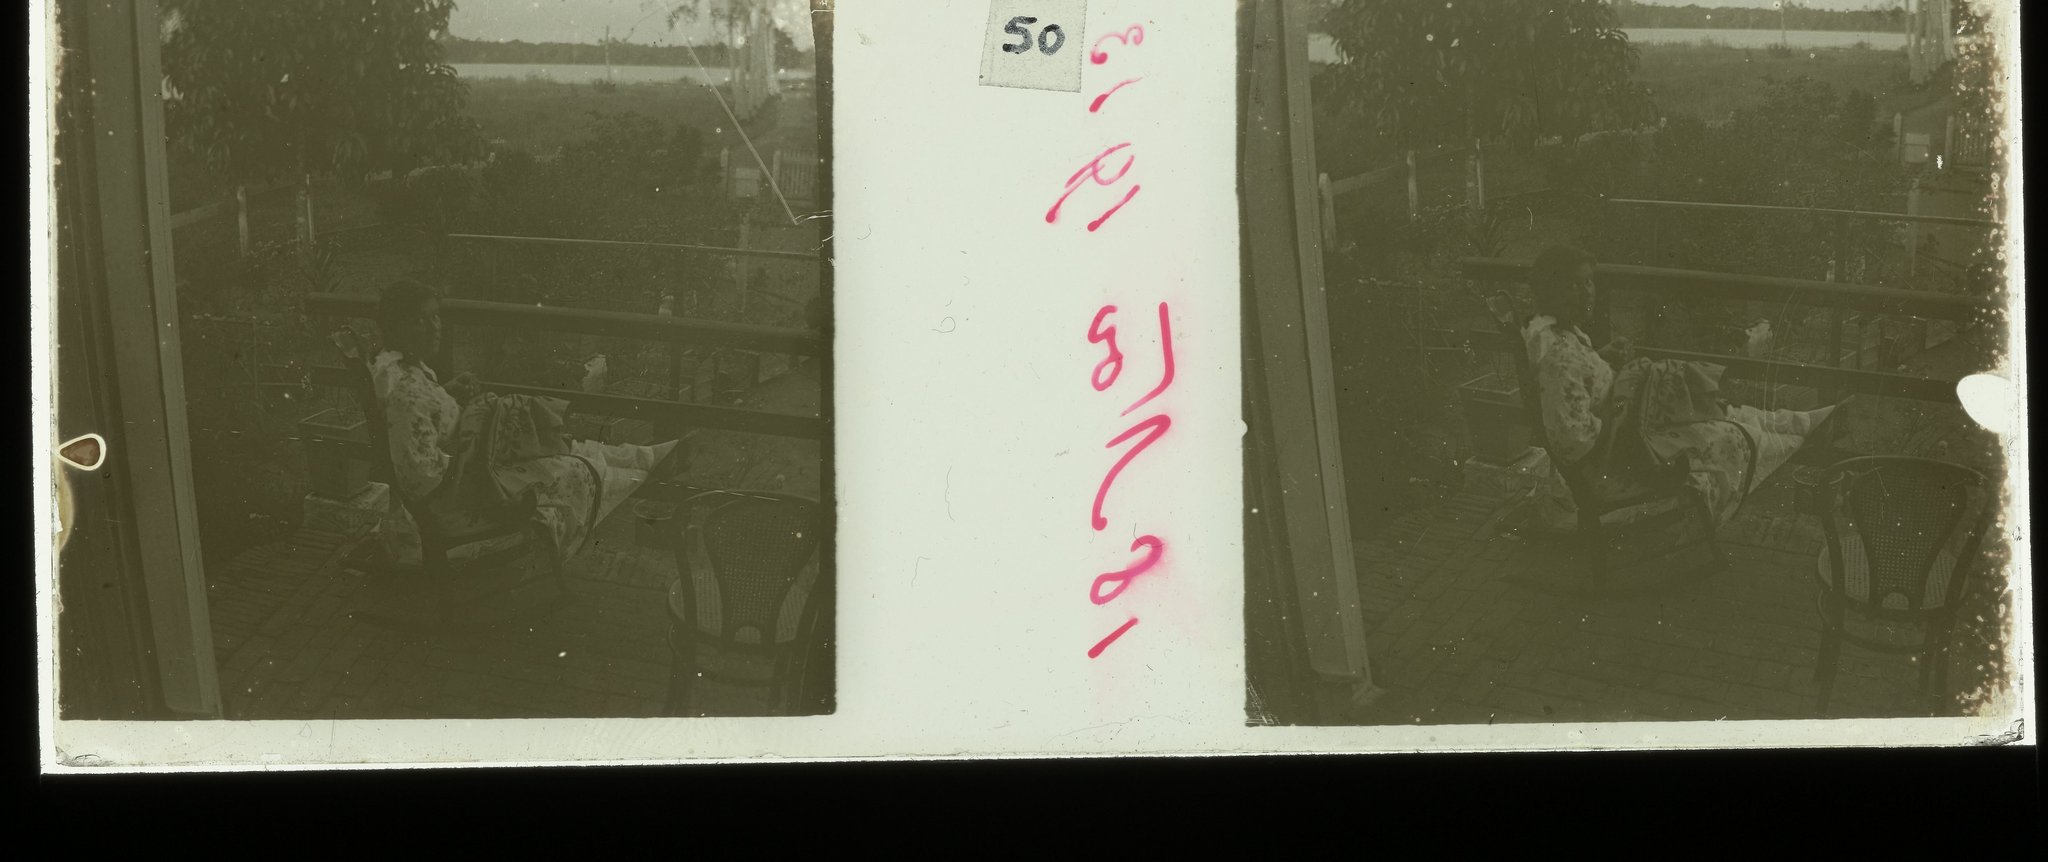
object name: stereograph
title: Plantage Accaribo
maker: theodoor brouwers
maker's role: amateurfotograaf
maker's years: 1874-1932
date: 1913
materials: glass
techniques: photography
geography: suriname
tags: amsterdam, theodoor brouwers, plantation, suriname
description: In de periode 1911-1932 woonde op plantage Accaribo in Suriname de familie Brouwers van wie de foto's afkomstig zijn. Rond 1910 vond Theodoor Brouwers werk op plantage Accaribo. In 1929 werd hij eigenaar van de plantage. Op Accaribo werden in zijn tijd bananen geproduceerd en wat koffie.